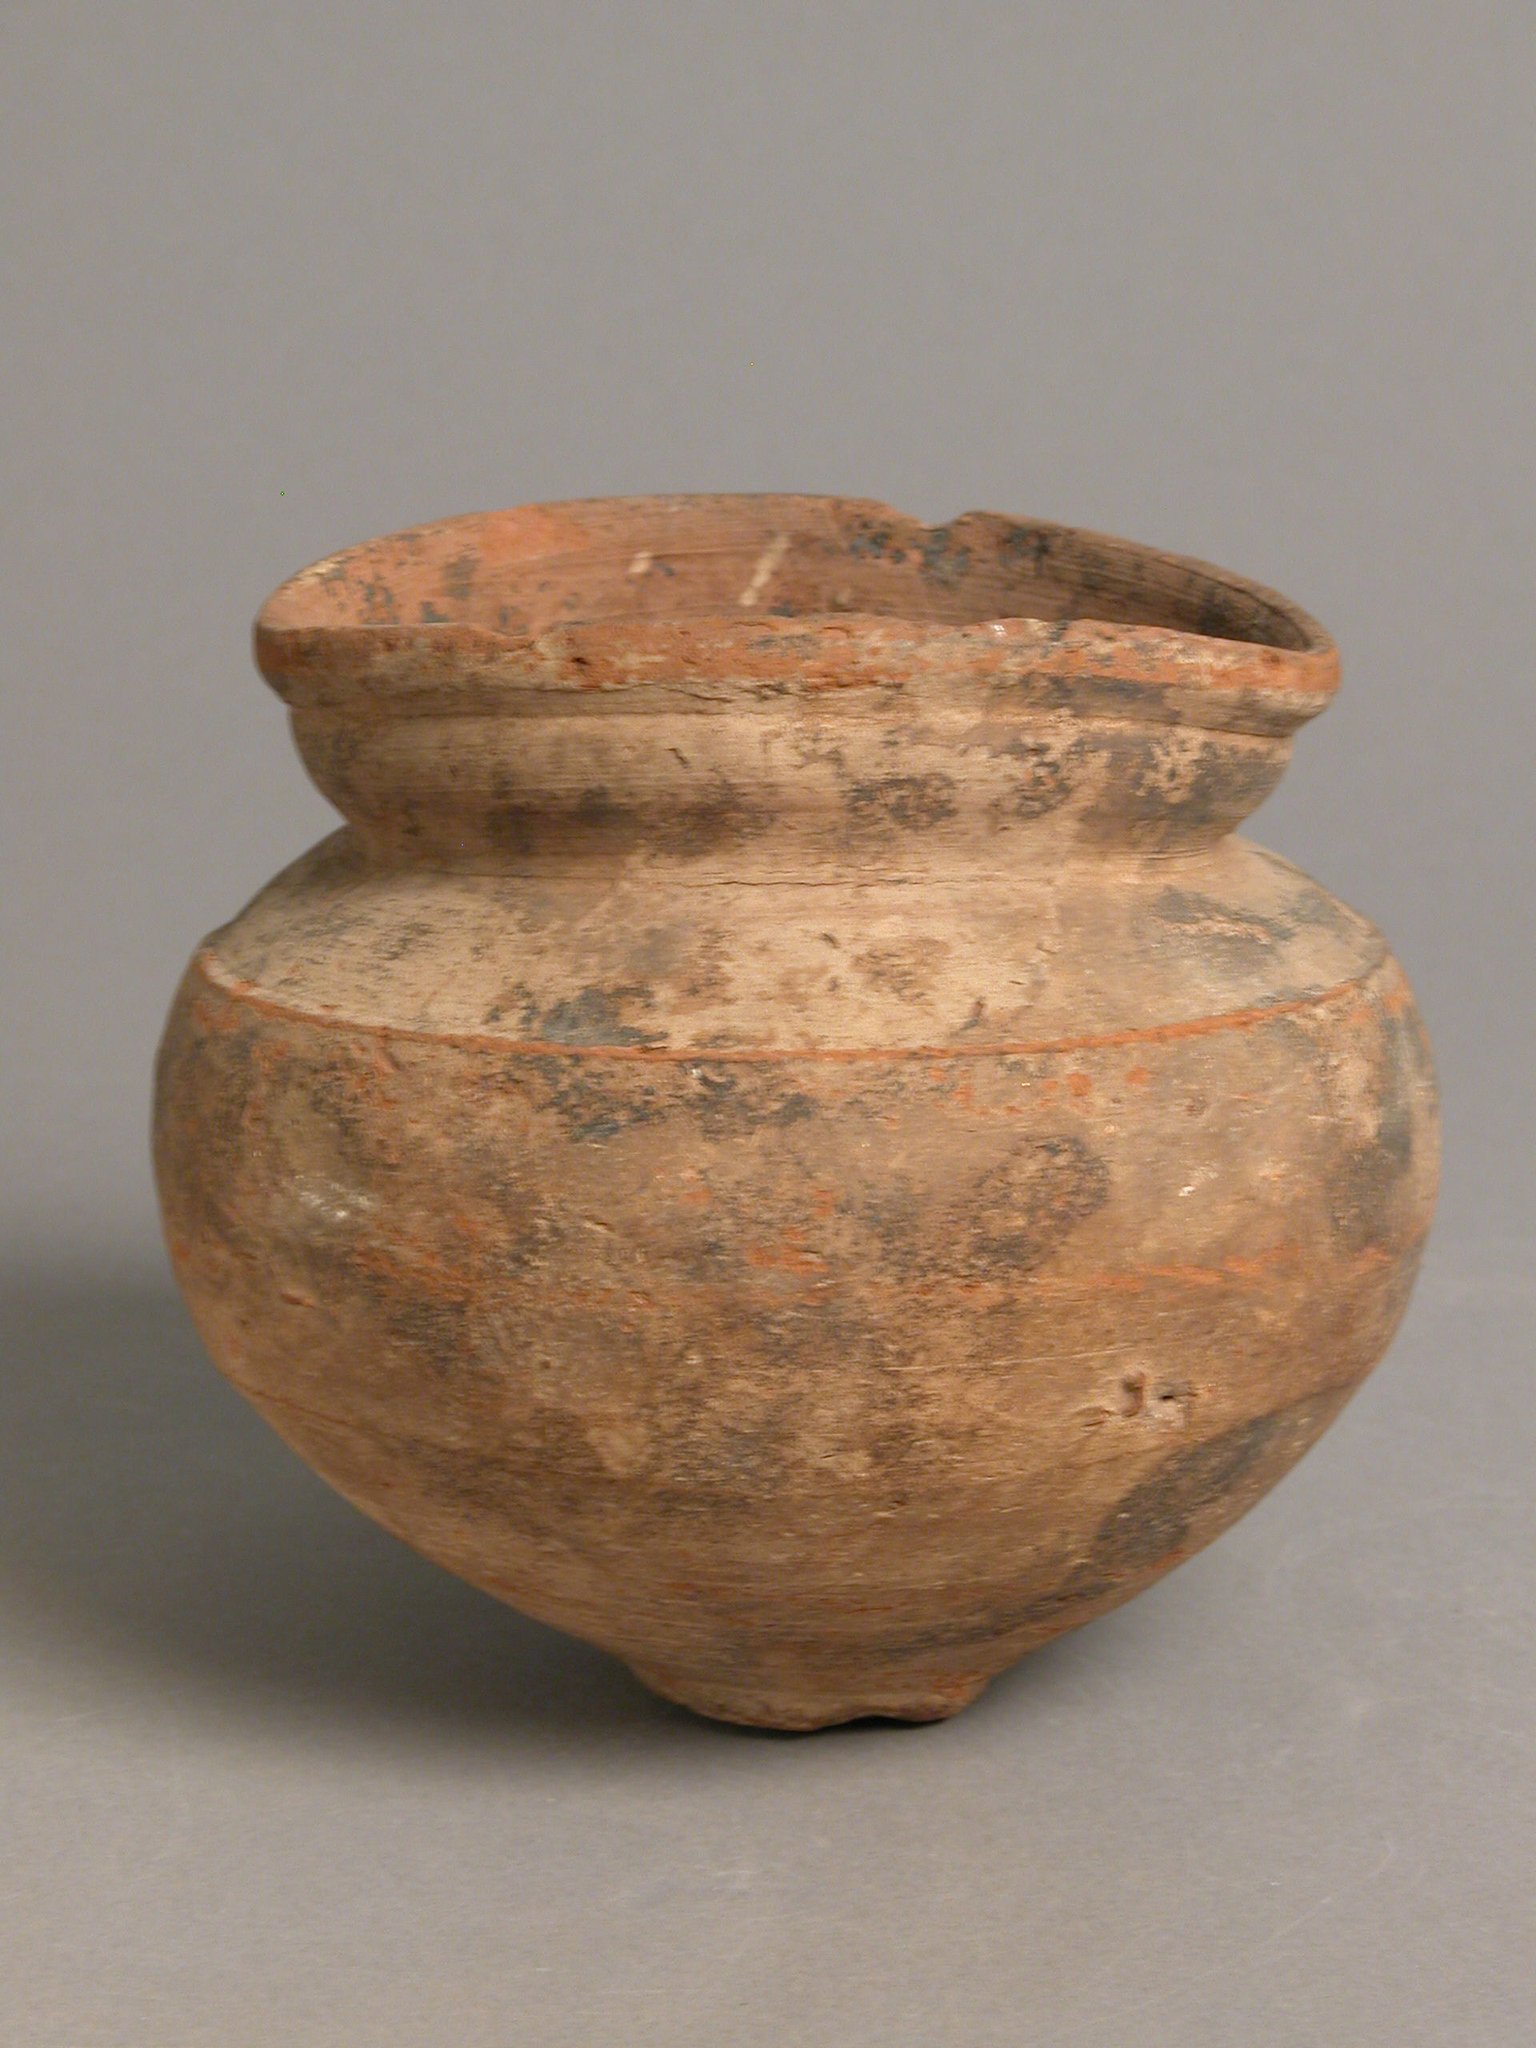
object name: jar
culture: coptic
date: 301-700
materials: earthenware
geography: egypt